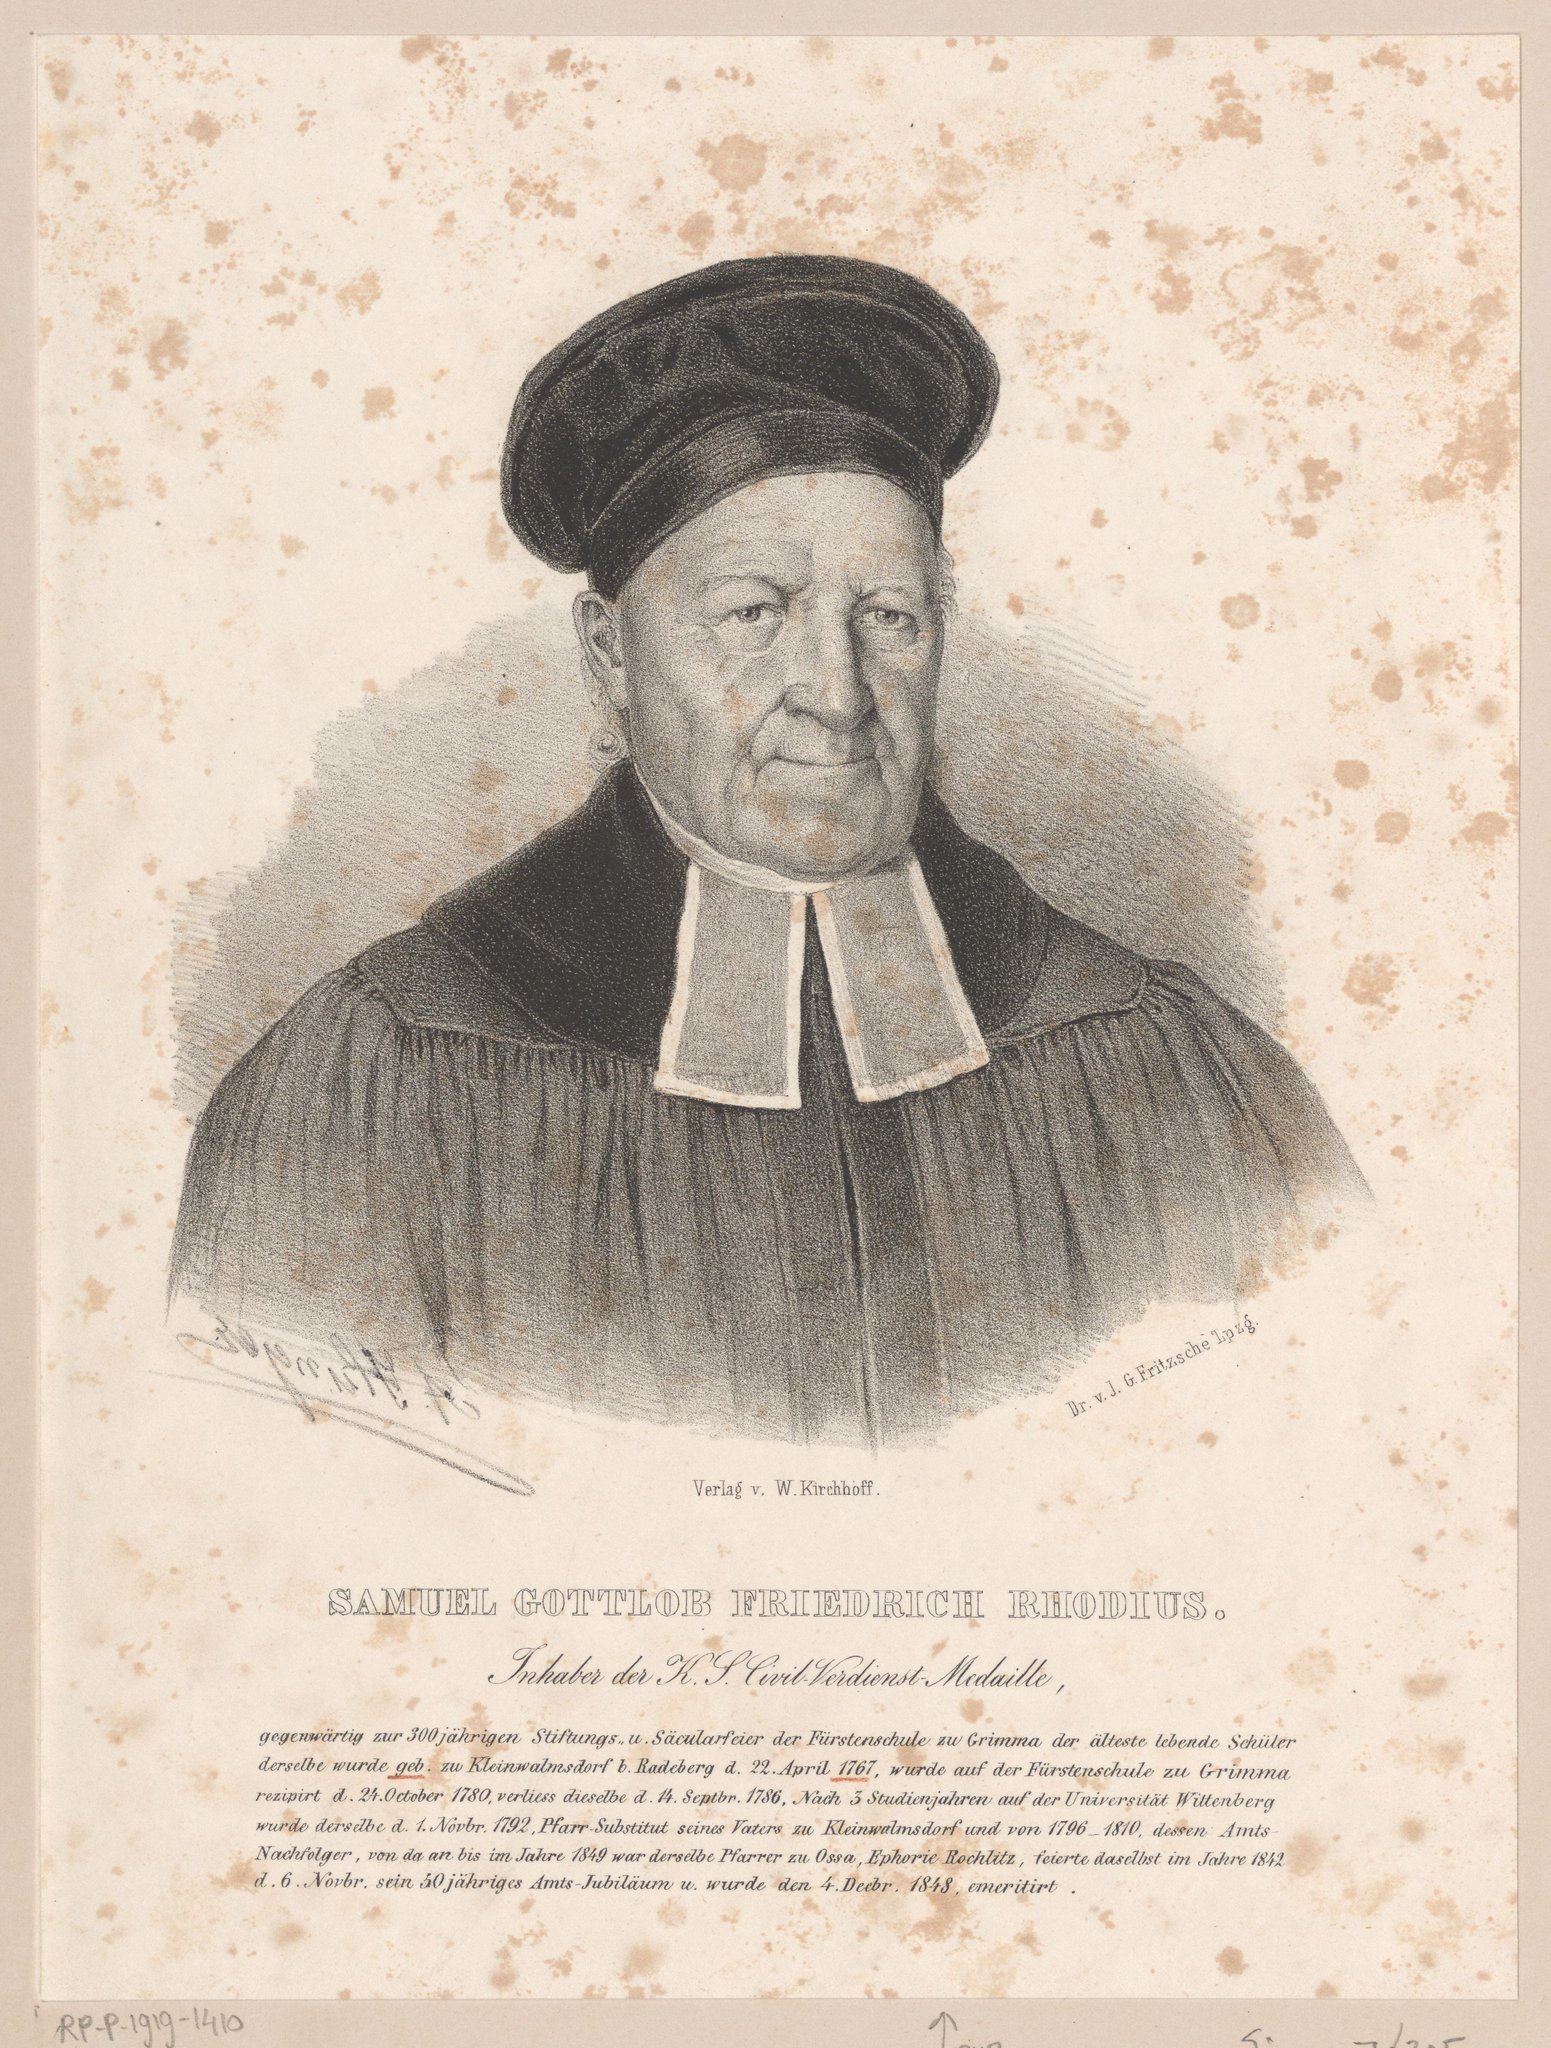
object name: print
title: Portret van Samuel Gottlob Friedrich Rhodius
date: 1848-1890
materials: paper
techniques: lithograph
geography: leipzig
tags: historical persons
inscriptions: collector's mark: Lugt 2228